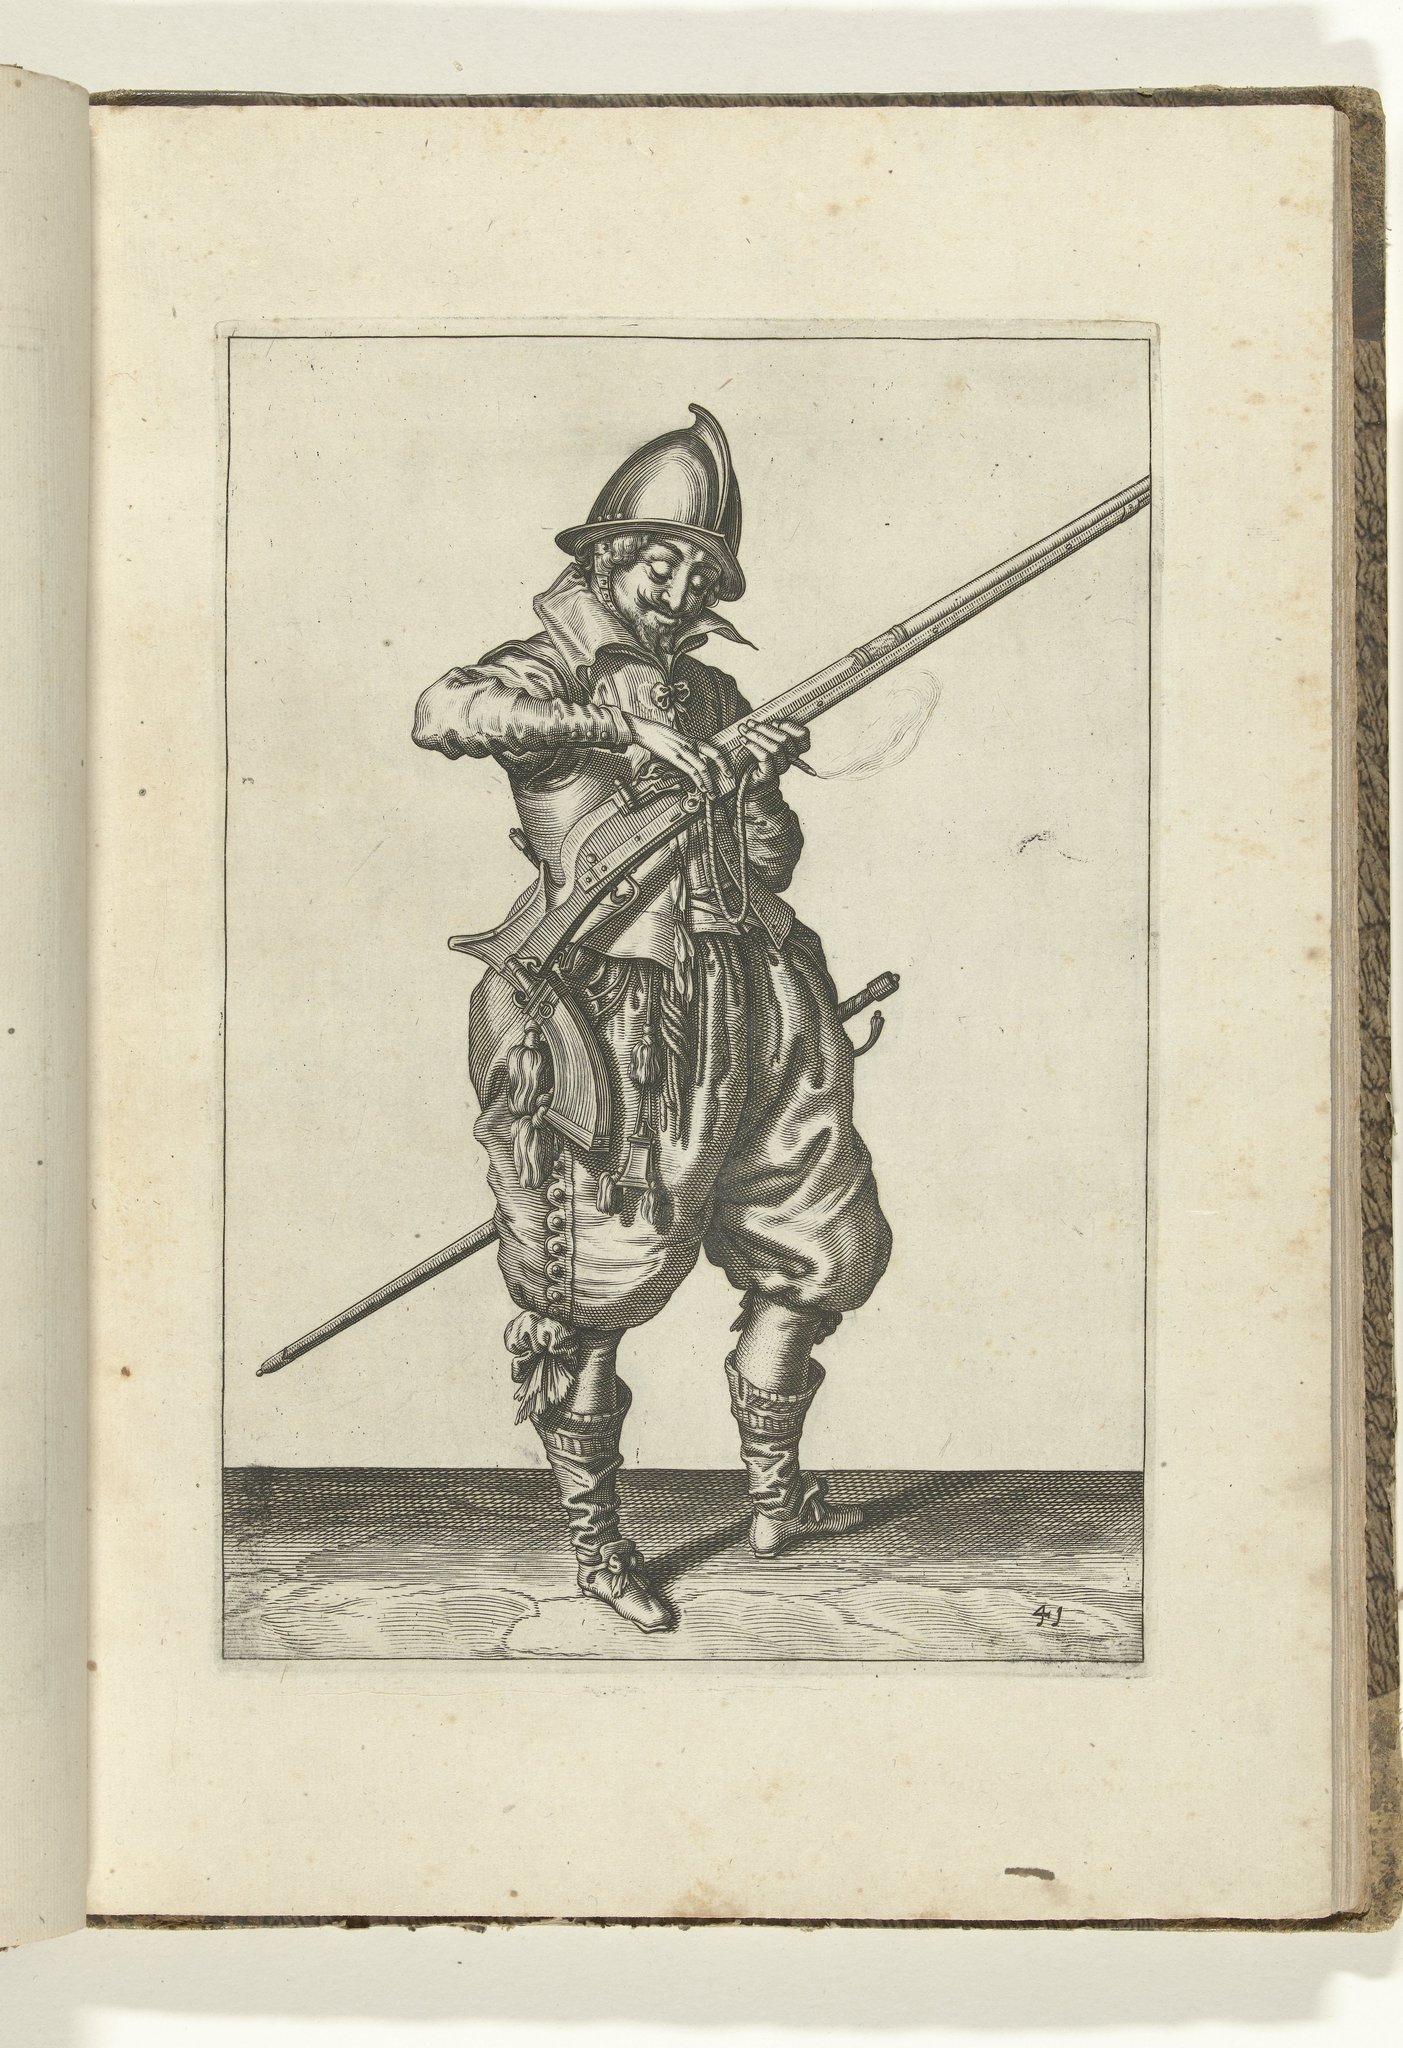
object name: print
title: Soldaat op wacht die de lont op de haan van zijn roer de juiste plek en vorm geeft (nr. 41), ca. 1600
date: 1597-1608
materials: paper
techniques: engraving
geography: northern netherlands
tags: the hague, maurice (prince of orange), handling of weapons ~ military training, weapons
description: Een soldaat op wacht, ten voeten uit, naar rechts, die een roer (een bepaald type vuurwapen) met zijn linkerhand vasthoudt (nr. 41), ca. 1600. Met duim en middelvinger van zijn rechterhand geeft hij de brandende lont op de haan (onderdeel van het ontstekingsmechanisme) van zijn roer de juiste plek en vorm. Het gaat dus om dezelfde positie als degene die op de achtste prent van de serie getoond wordt. Plaat 41 in de instructies voor het hanteren van de roer: Brief enseignement, sur la representation des figures, du droit maniement de l'Harquebuse. Onderdeel van de illustraties in een Franse editie van J. de Gheyns Wapenhandelinghe: J. de Gheyn, Maniement d'armes, d'arquebuses, mousquetz et piques : en conformité de l'ordre de Mour le Prince Maurice, Prince d'Orange, Amsterdam 1608. Krijgswezen rond 1600.